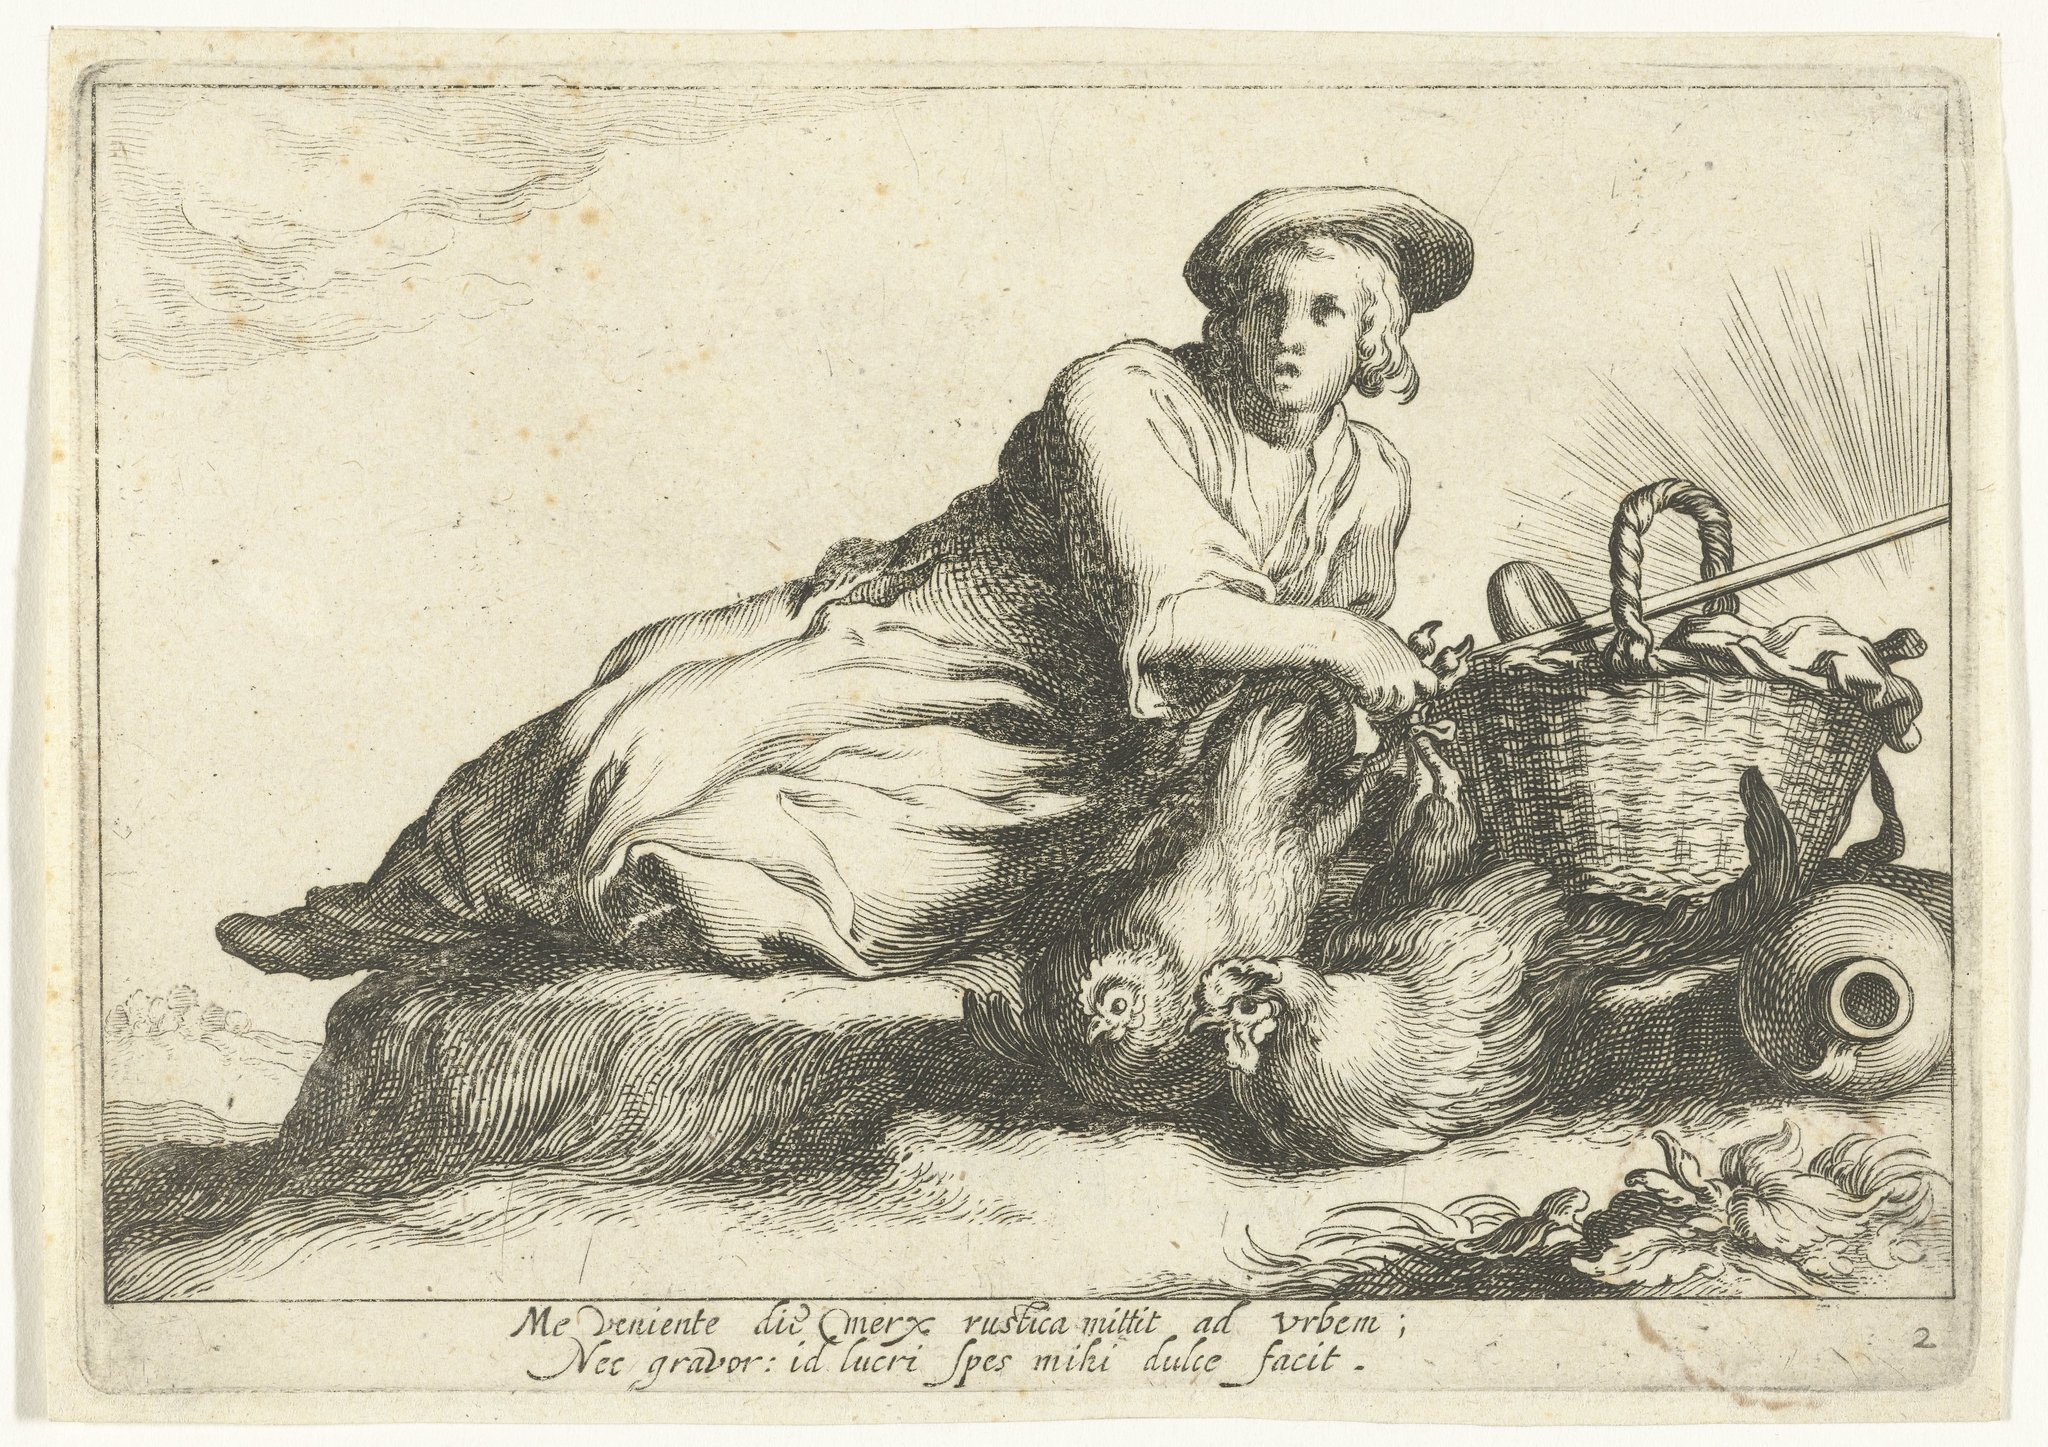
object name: print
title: Vrouw met kippen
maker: cornelis bloemaert (ii)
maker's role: draughtsman, print maker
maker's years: 1603-1692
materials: paper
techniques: engraving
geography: utrecht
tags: pastorals, arcadian scenes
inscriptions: collector's mark: Lugt 240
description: Een vrouw ligt te rusten met een mand en twee kippen naast haar. Met onderschrift in het Latijn.